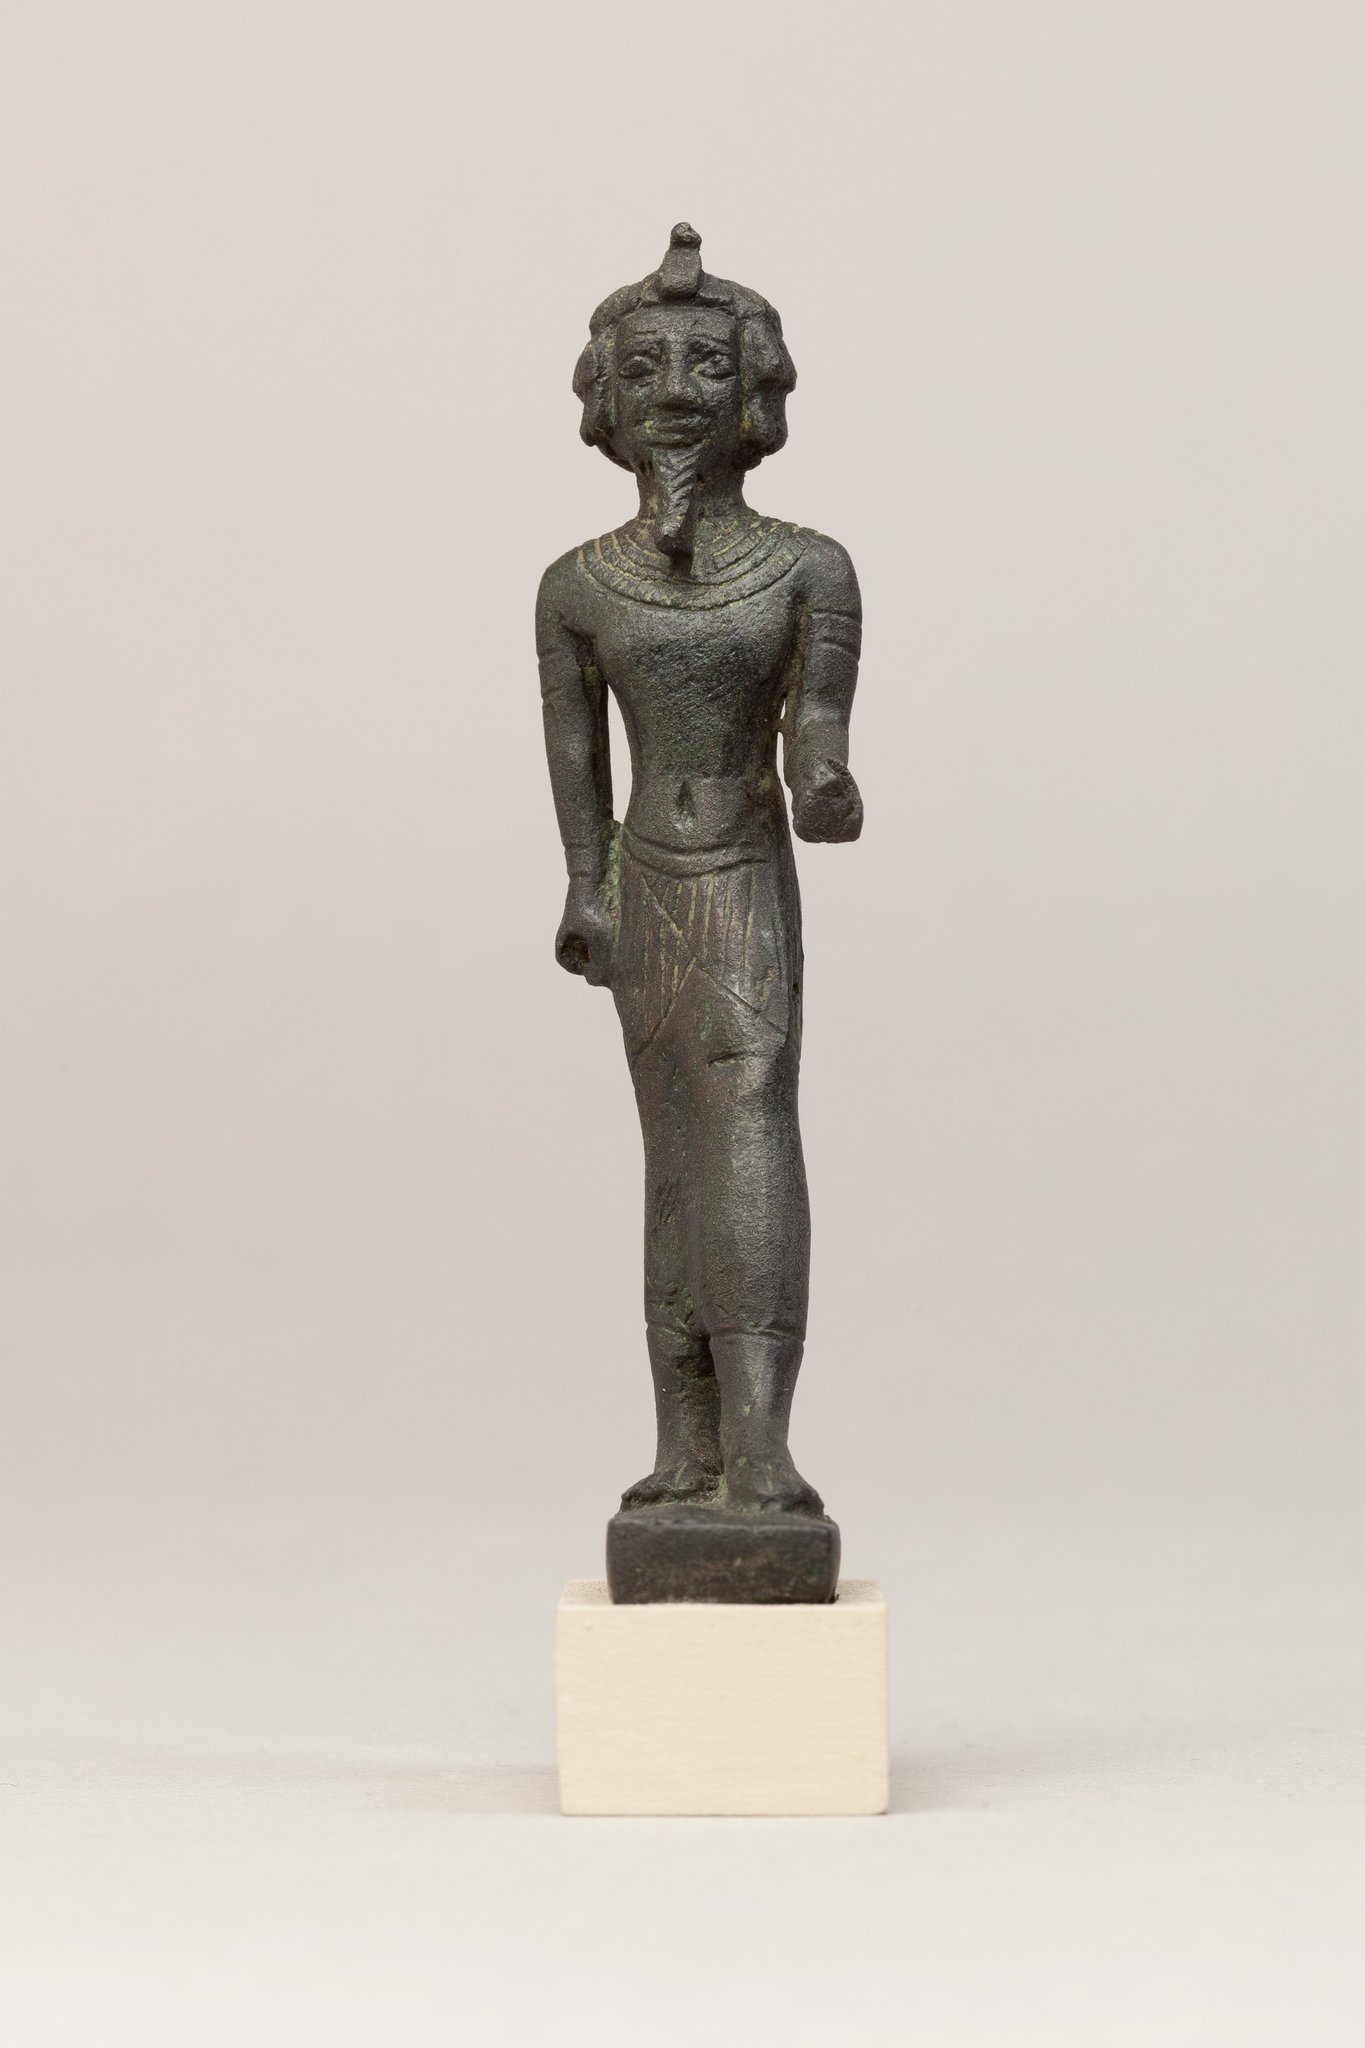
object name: statuette, onuris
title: Onuris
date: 664-630 BCE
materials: metal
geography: egypt